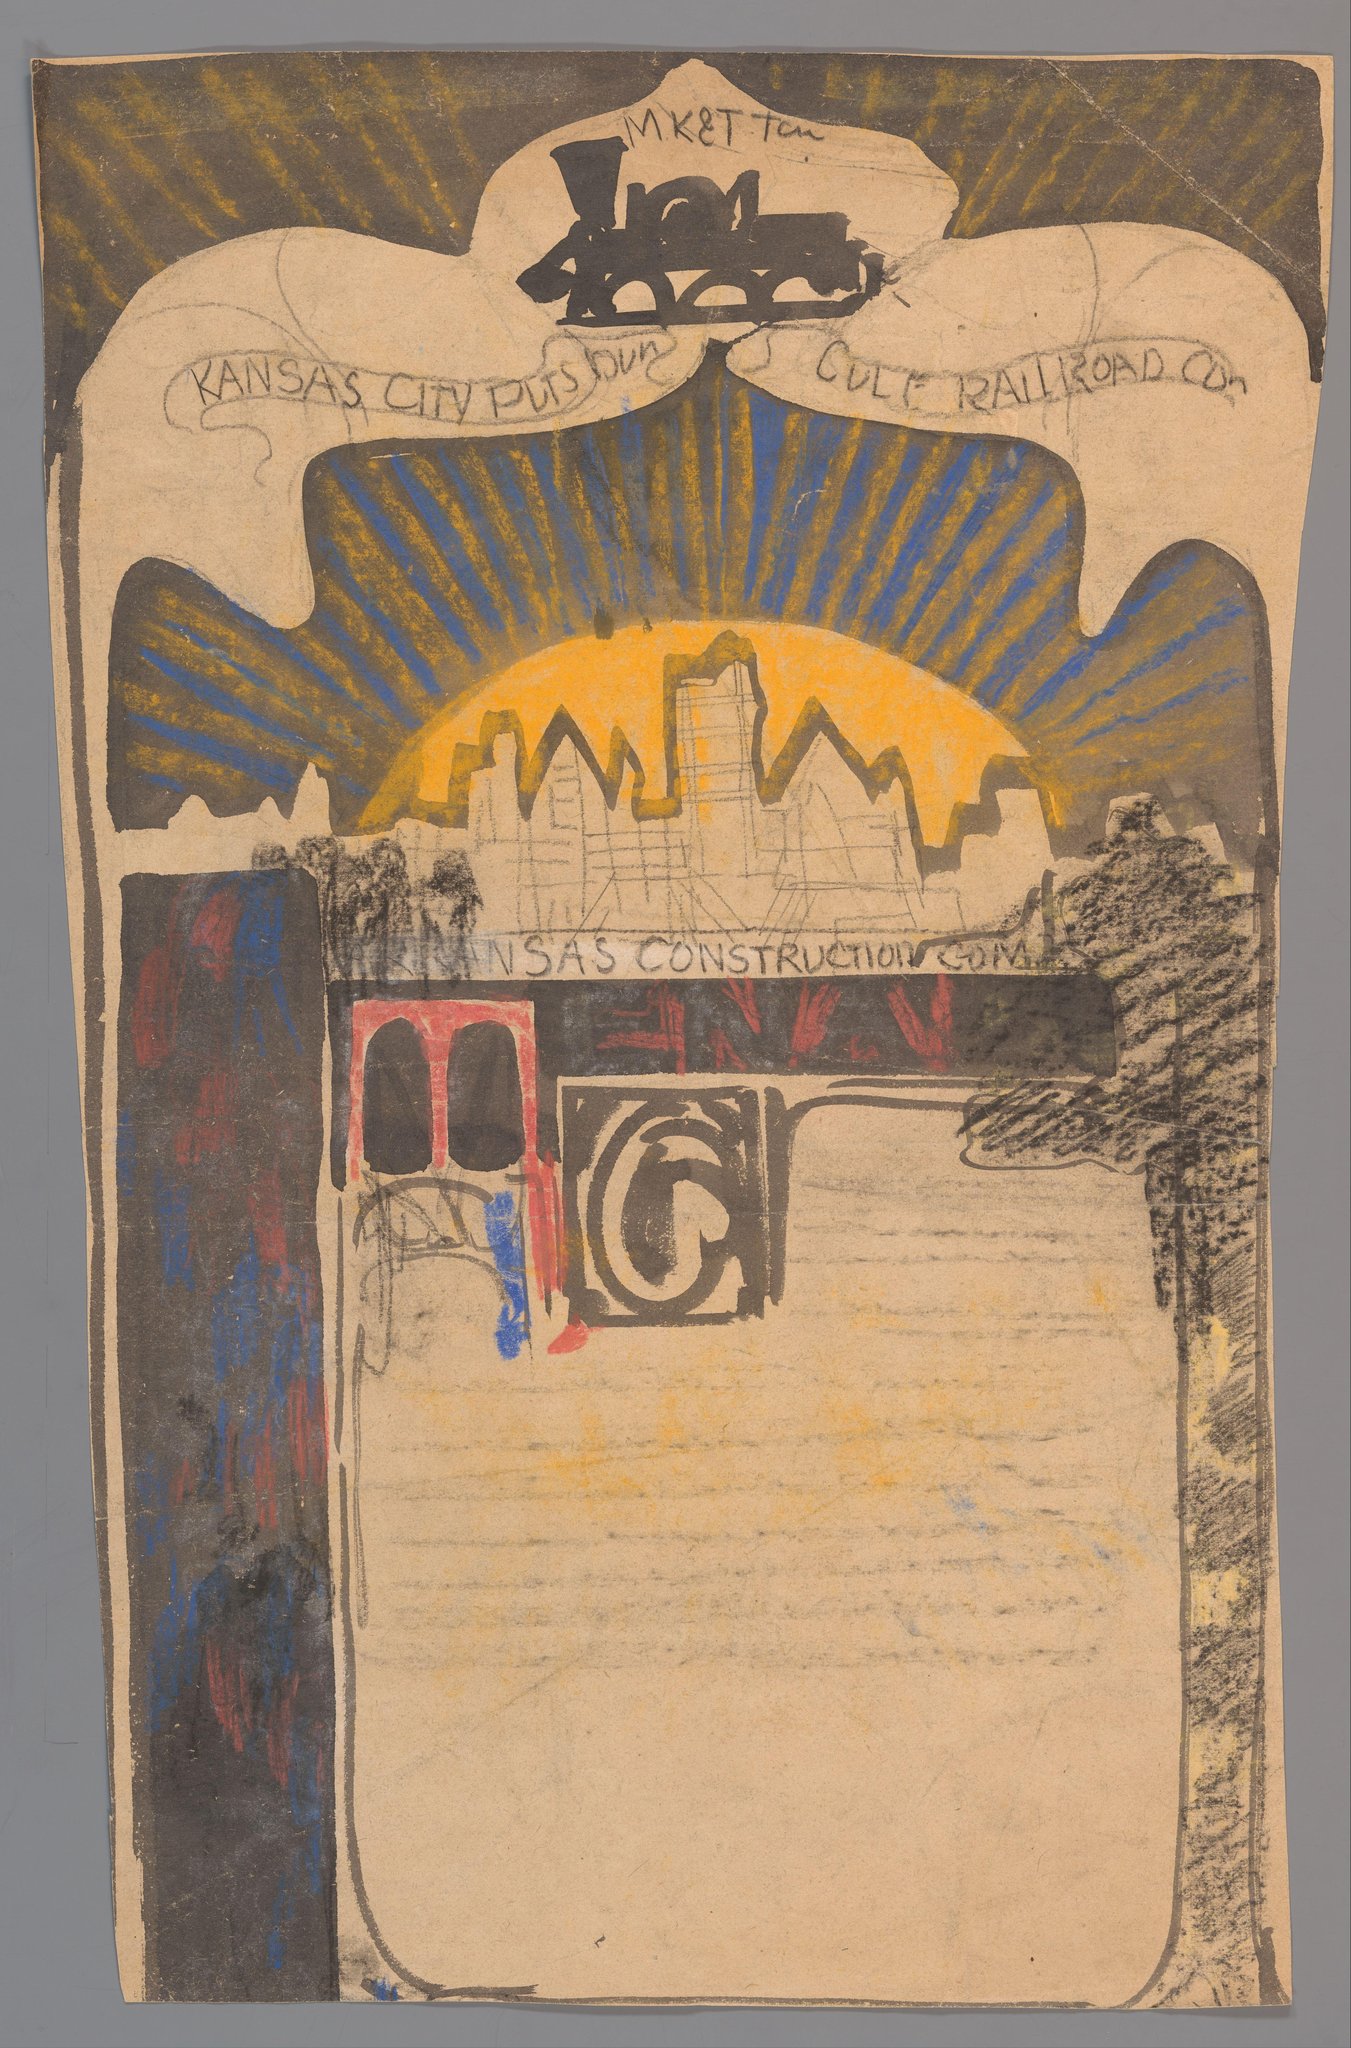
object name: design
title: Ontwerp voor een aandeel van de Arkansas Construction Company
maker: carel adolph lion cachet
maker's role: draughtsman, print maker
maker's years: 1864-1945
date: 1874-1945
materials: chalk, paper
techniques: brush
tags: iou (= i owe you), bond, names of organizations, companies, trade unions, etc.